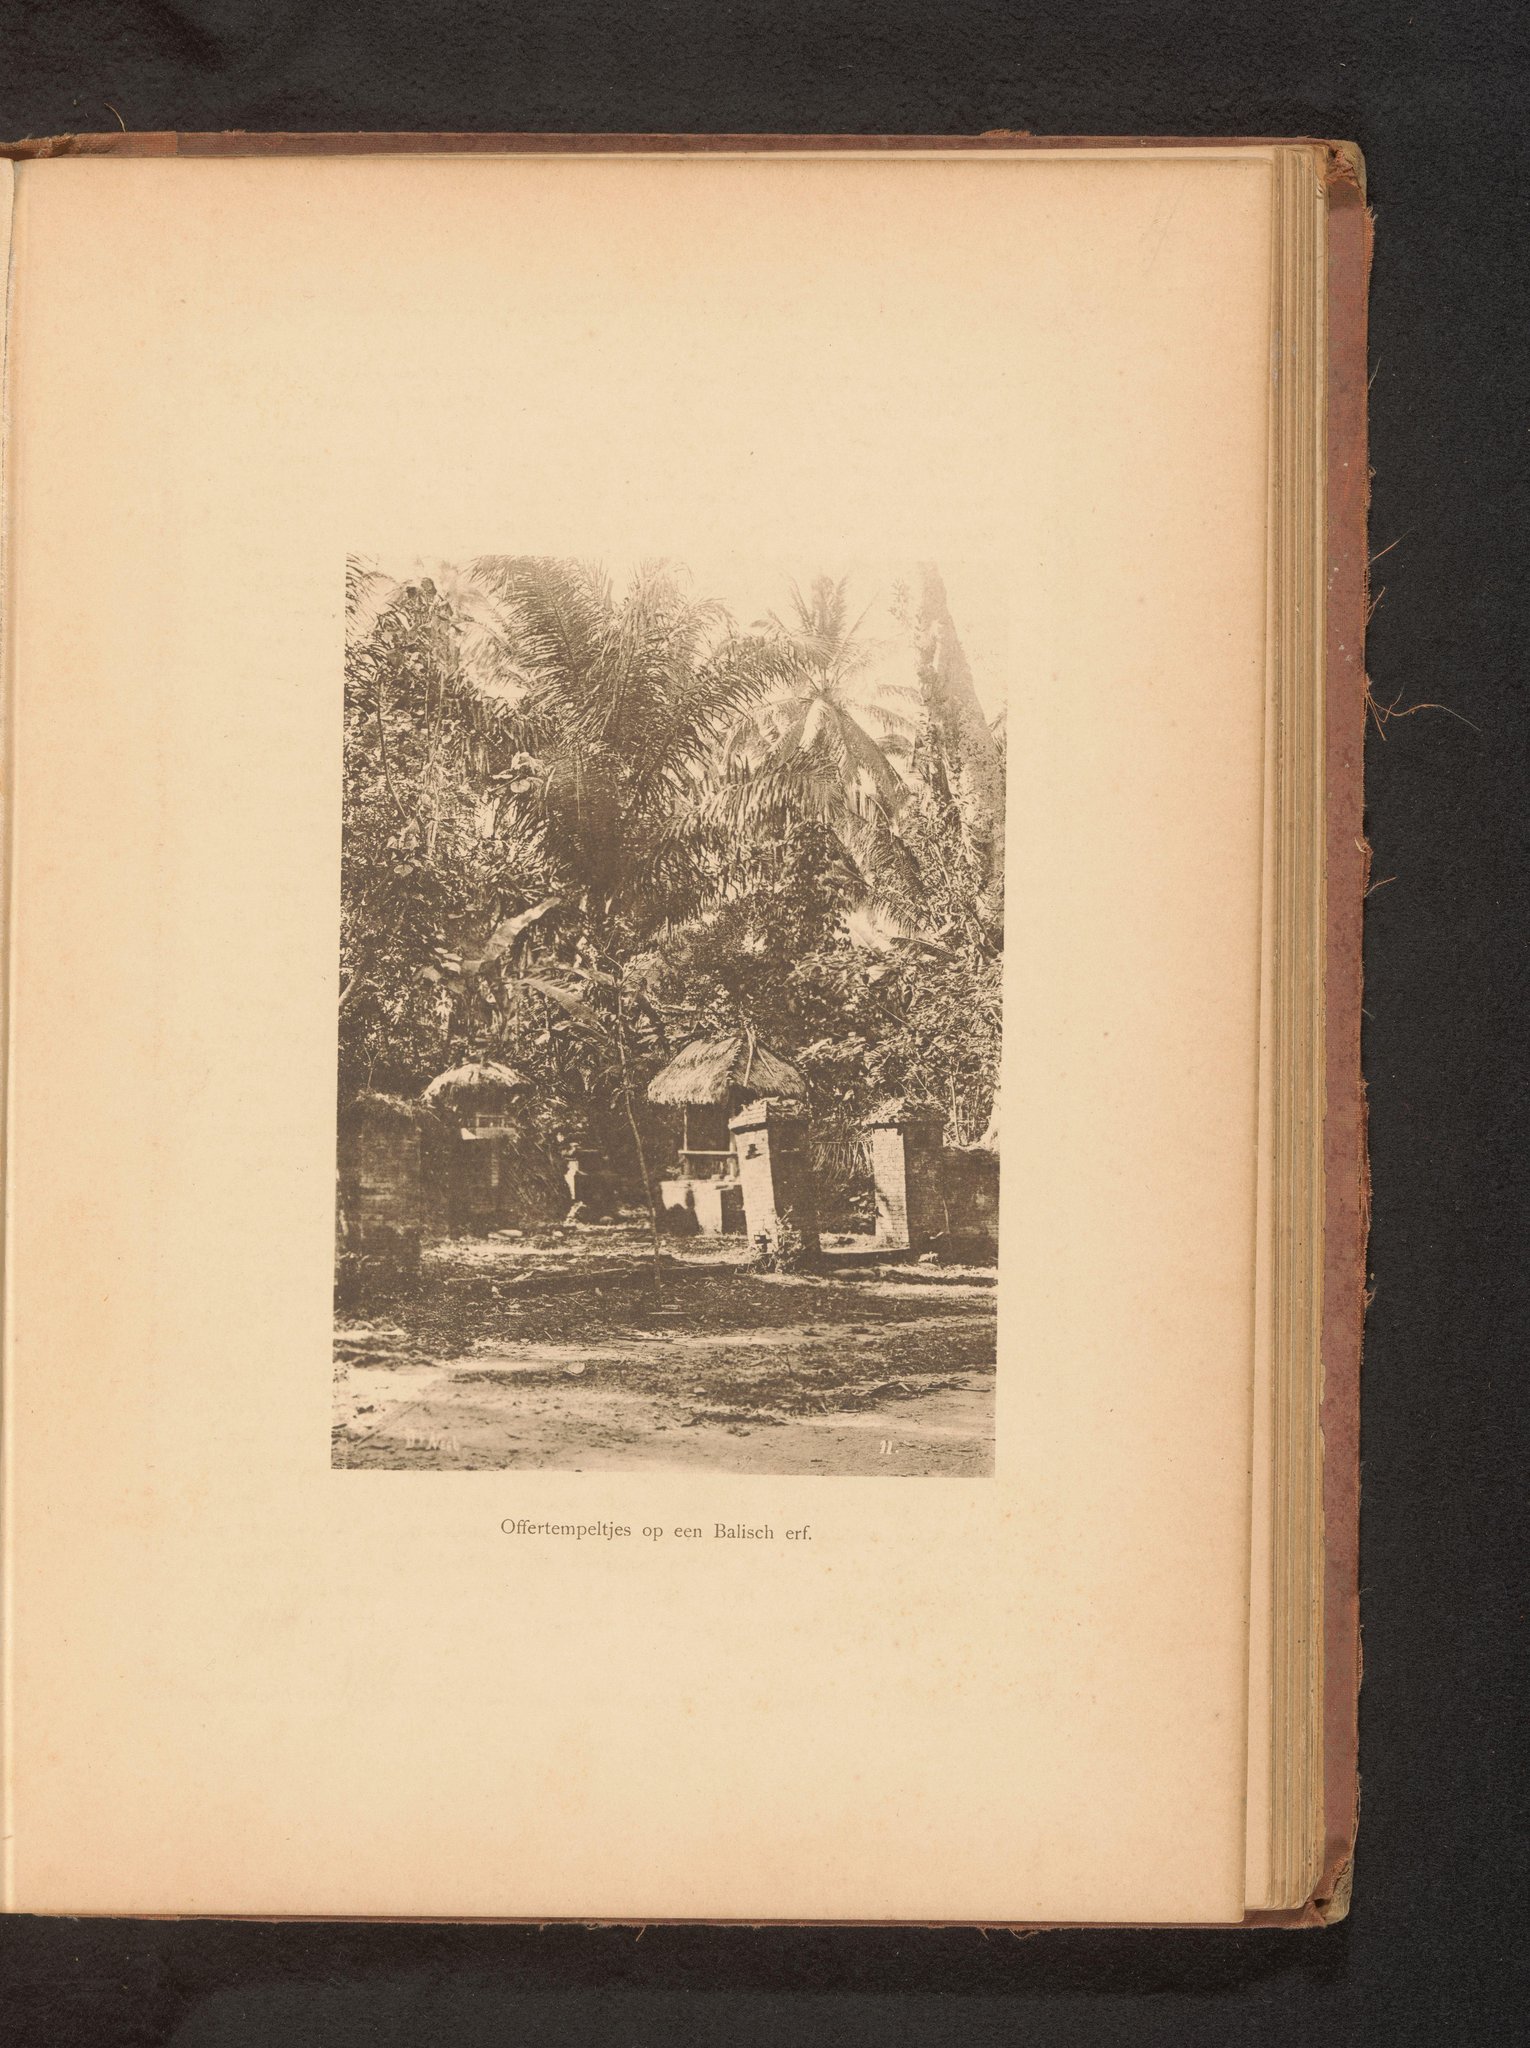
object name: page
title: Gezicht op een offertempel in een bebost gebied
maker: christiaan johan neeb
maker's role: arts, fotograaf, officier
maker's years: 1860-1925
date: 1892-1897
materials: paper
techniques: photograph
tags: trees, places and objects of worship ~ non-christian religions, indonesia